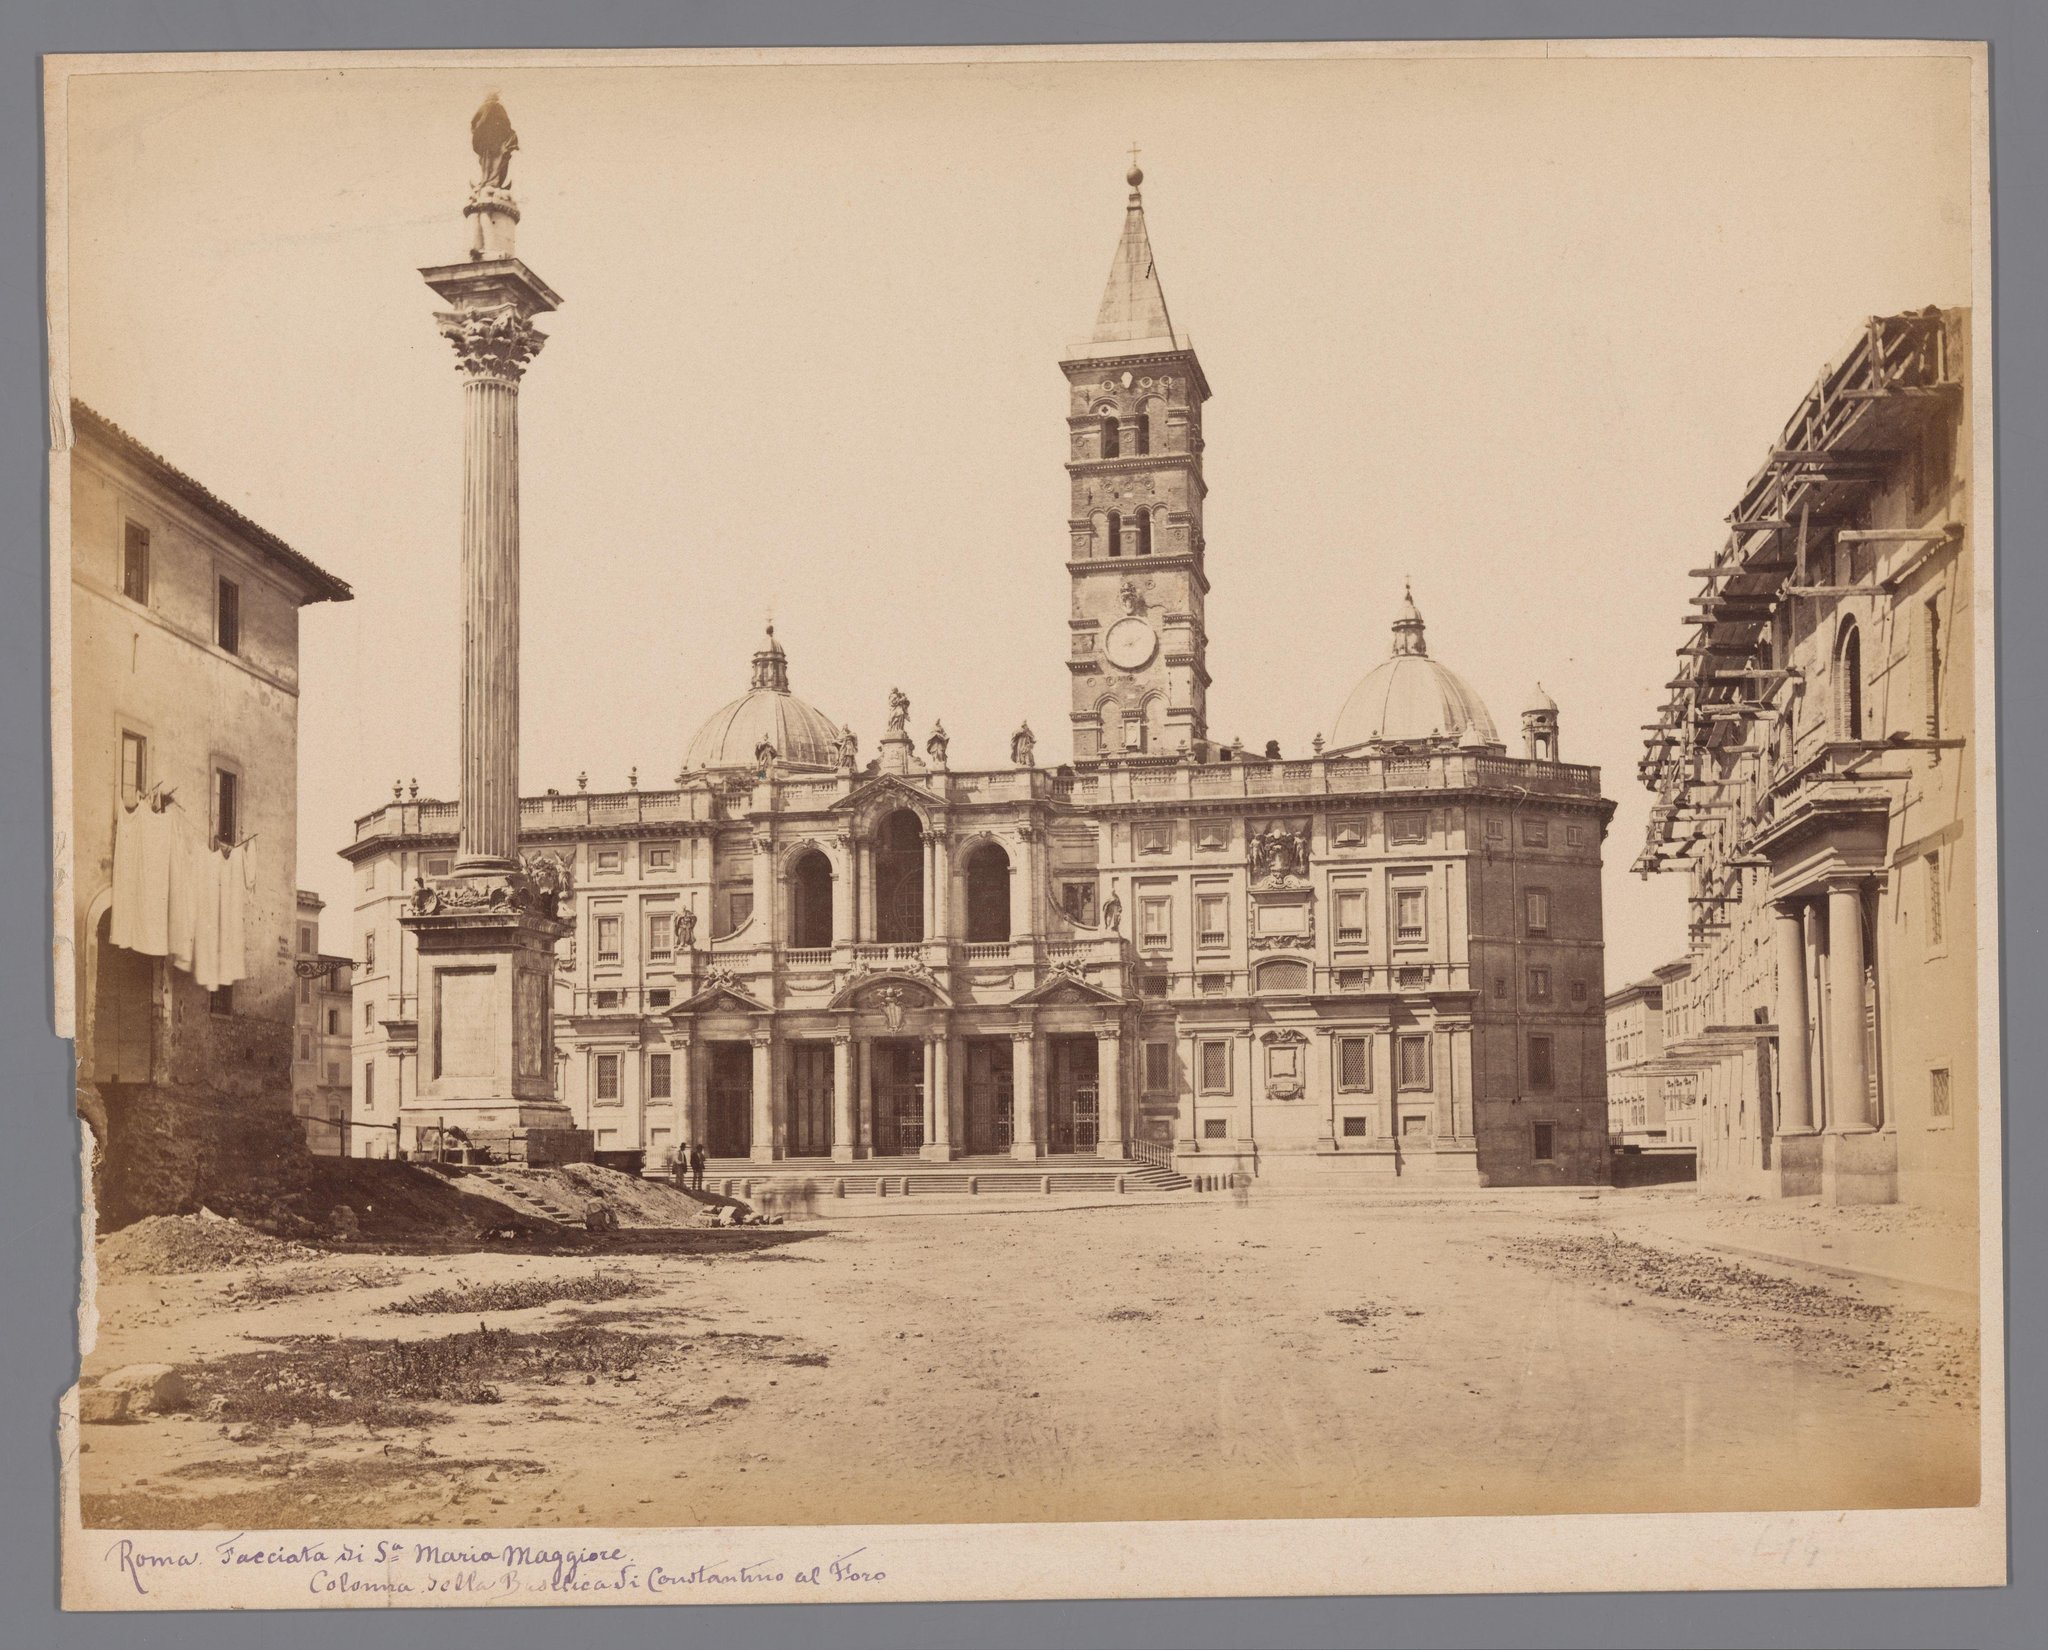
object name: photograph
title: Roma Facciata di Sa. Maria Maggiore. Colonna della Basilica di Constantino al Foro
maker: Anonymous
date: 1851-1900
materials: cardboard, paper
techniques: albumen print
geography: rome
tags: square, place, circus, etc., obelisk, needle, church (exterior)